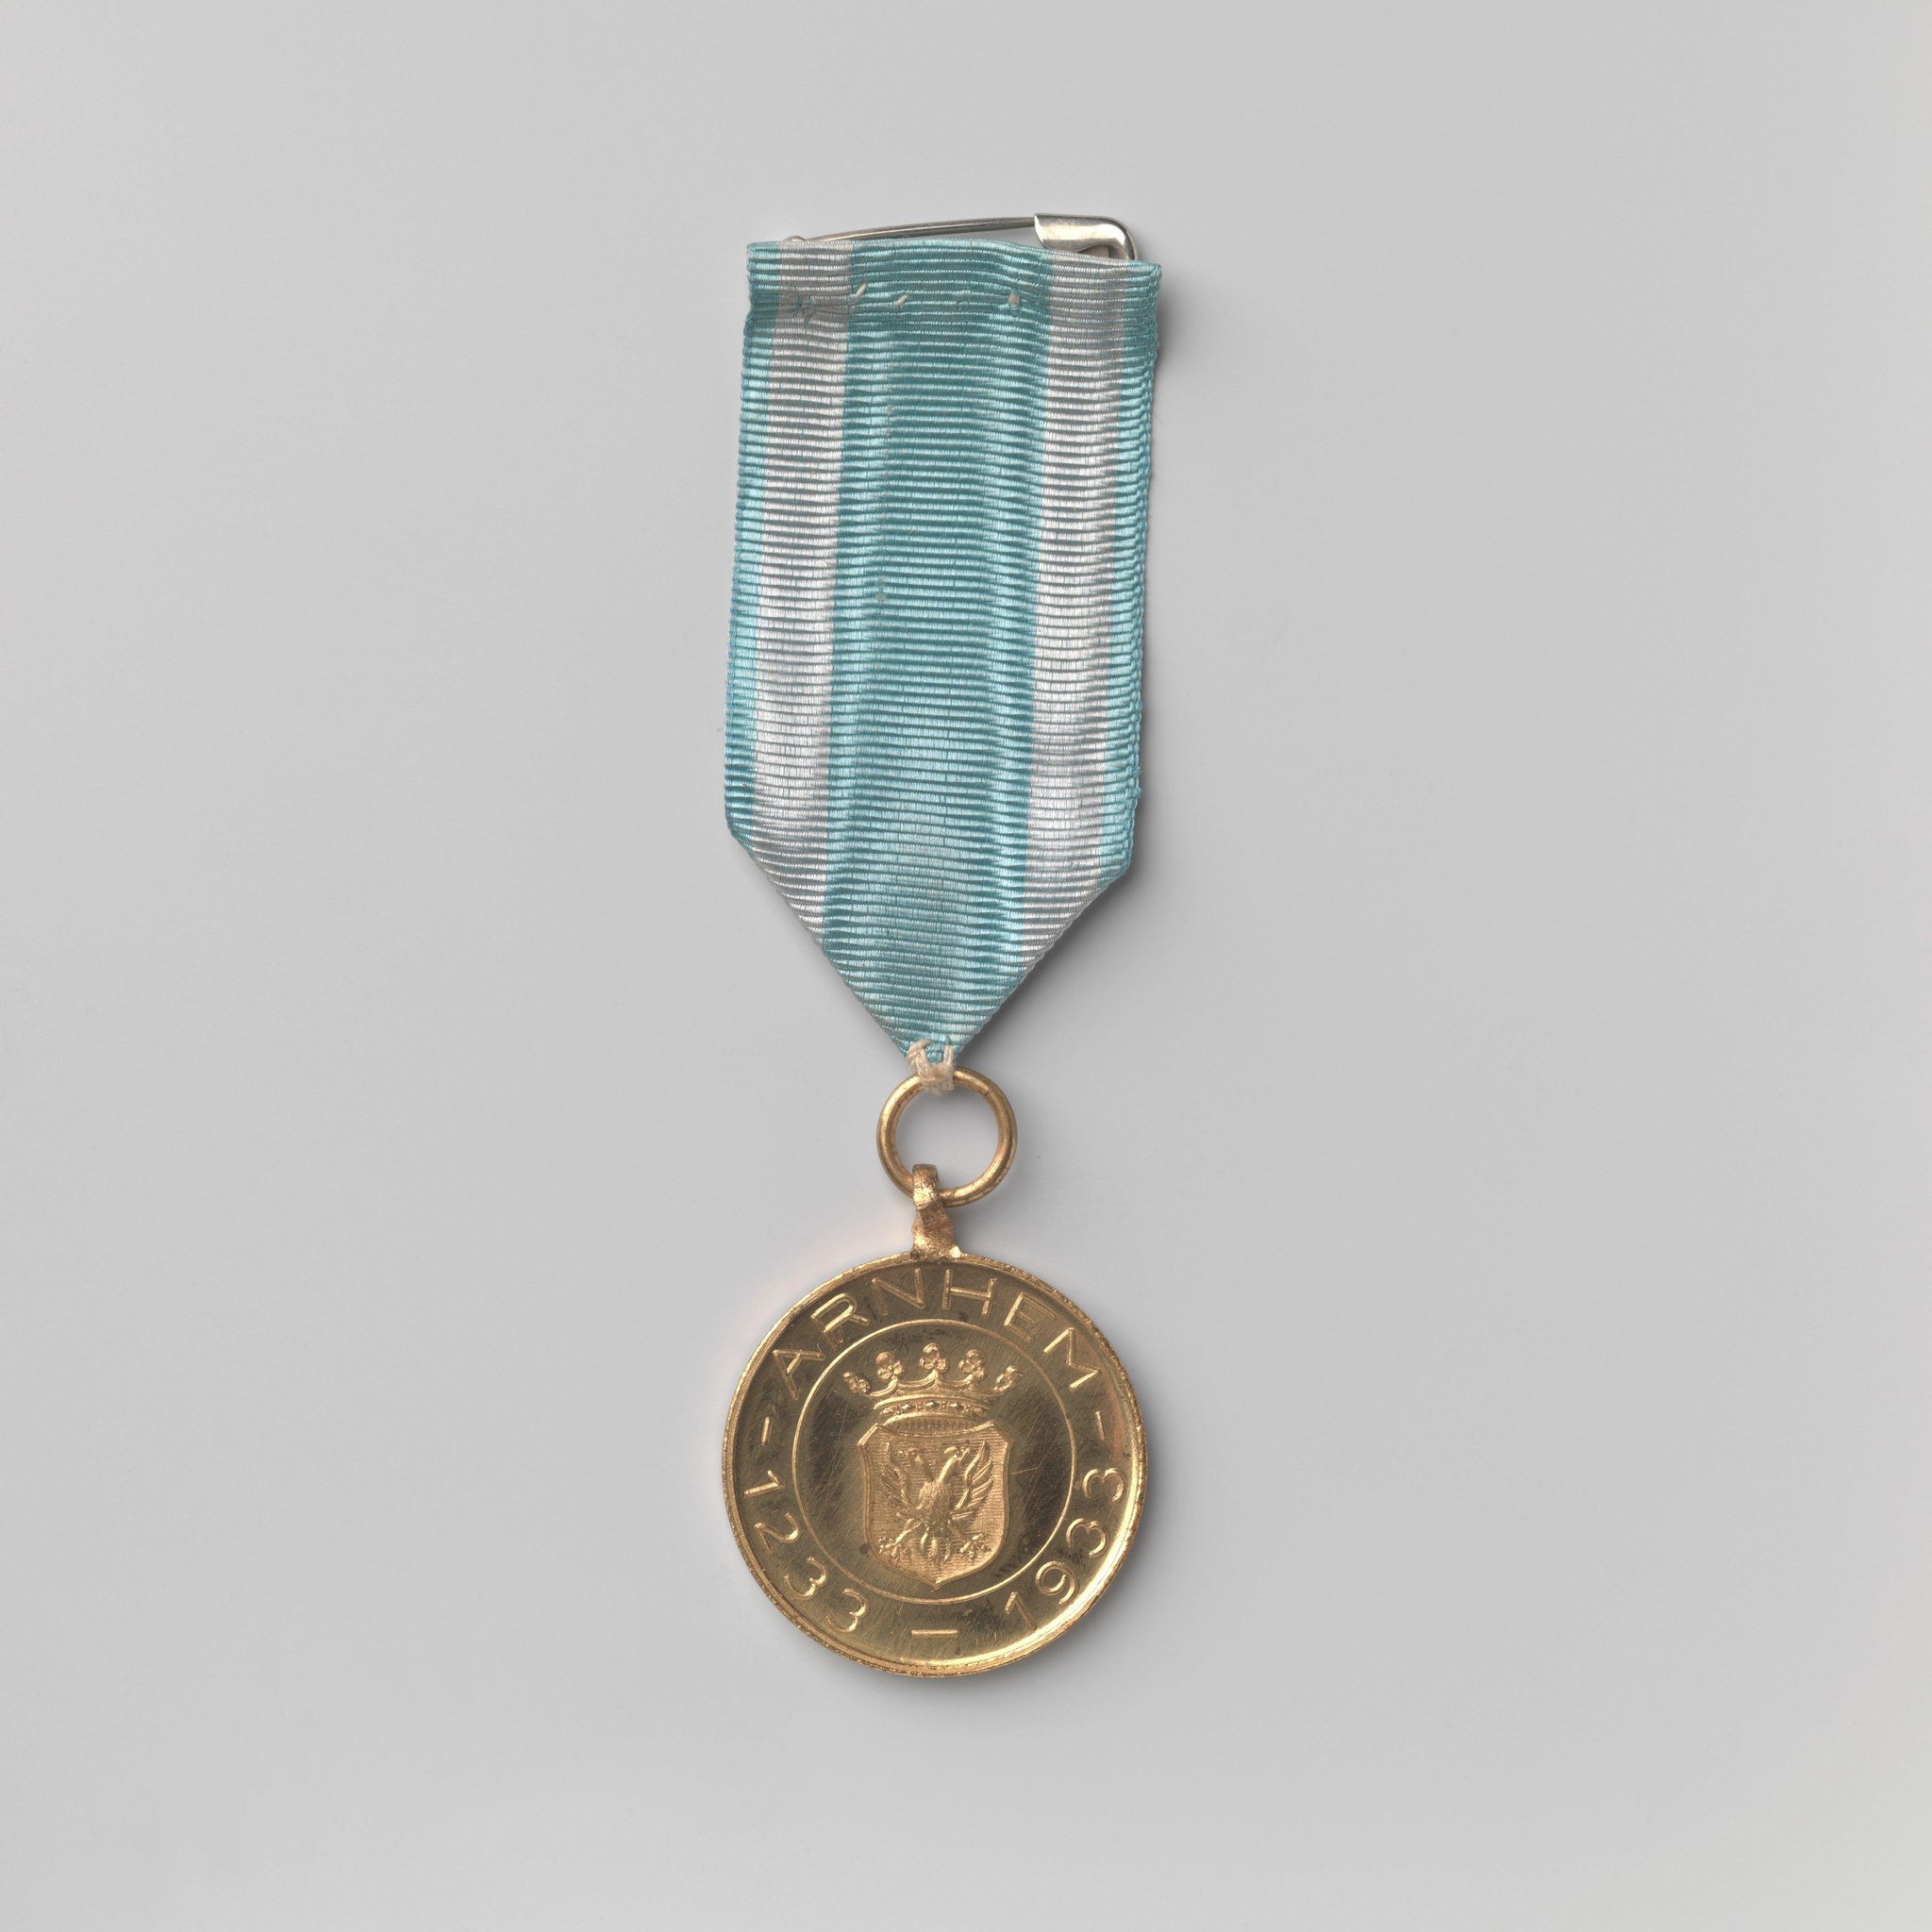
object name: insignia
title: Zevenhonderdjarig bestaan van Arnhem als stad 1933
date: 1933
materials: brass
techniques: striking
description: Messing draagpenning met oog en draagring aan een blauw lint met twee witte biezen, op de voorzijde een burcht in vogelvlucht, op de keerzijde het gekroonde wapenschild van Arnhem met omschrift.